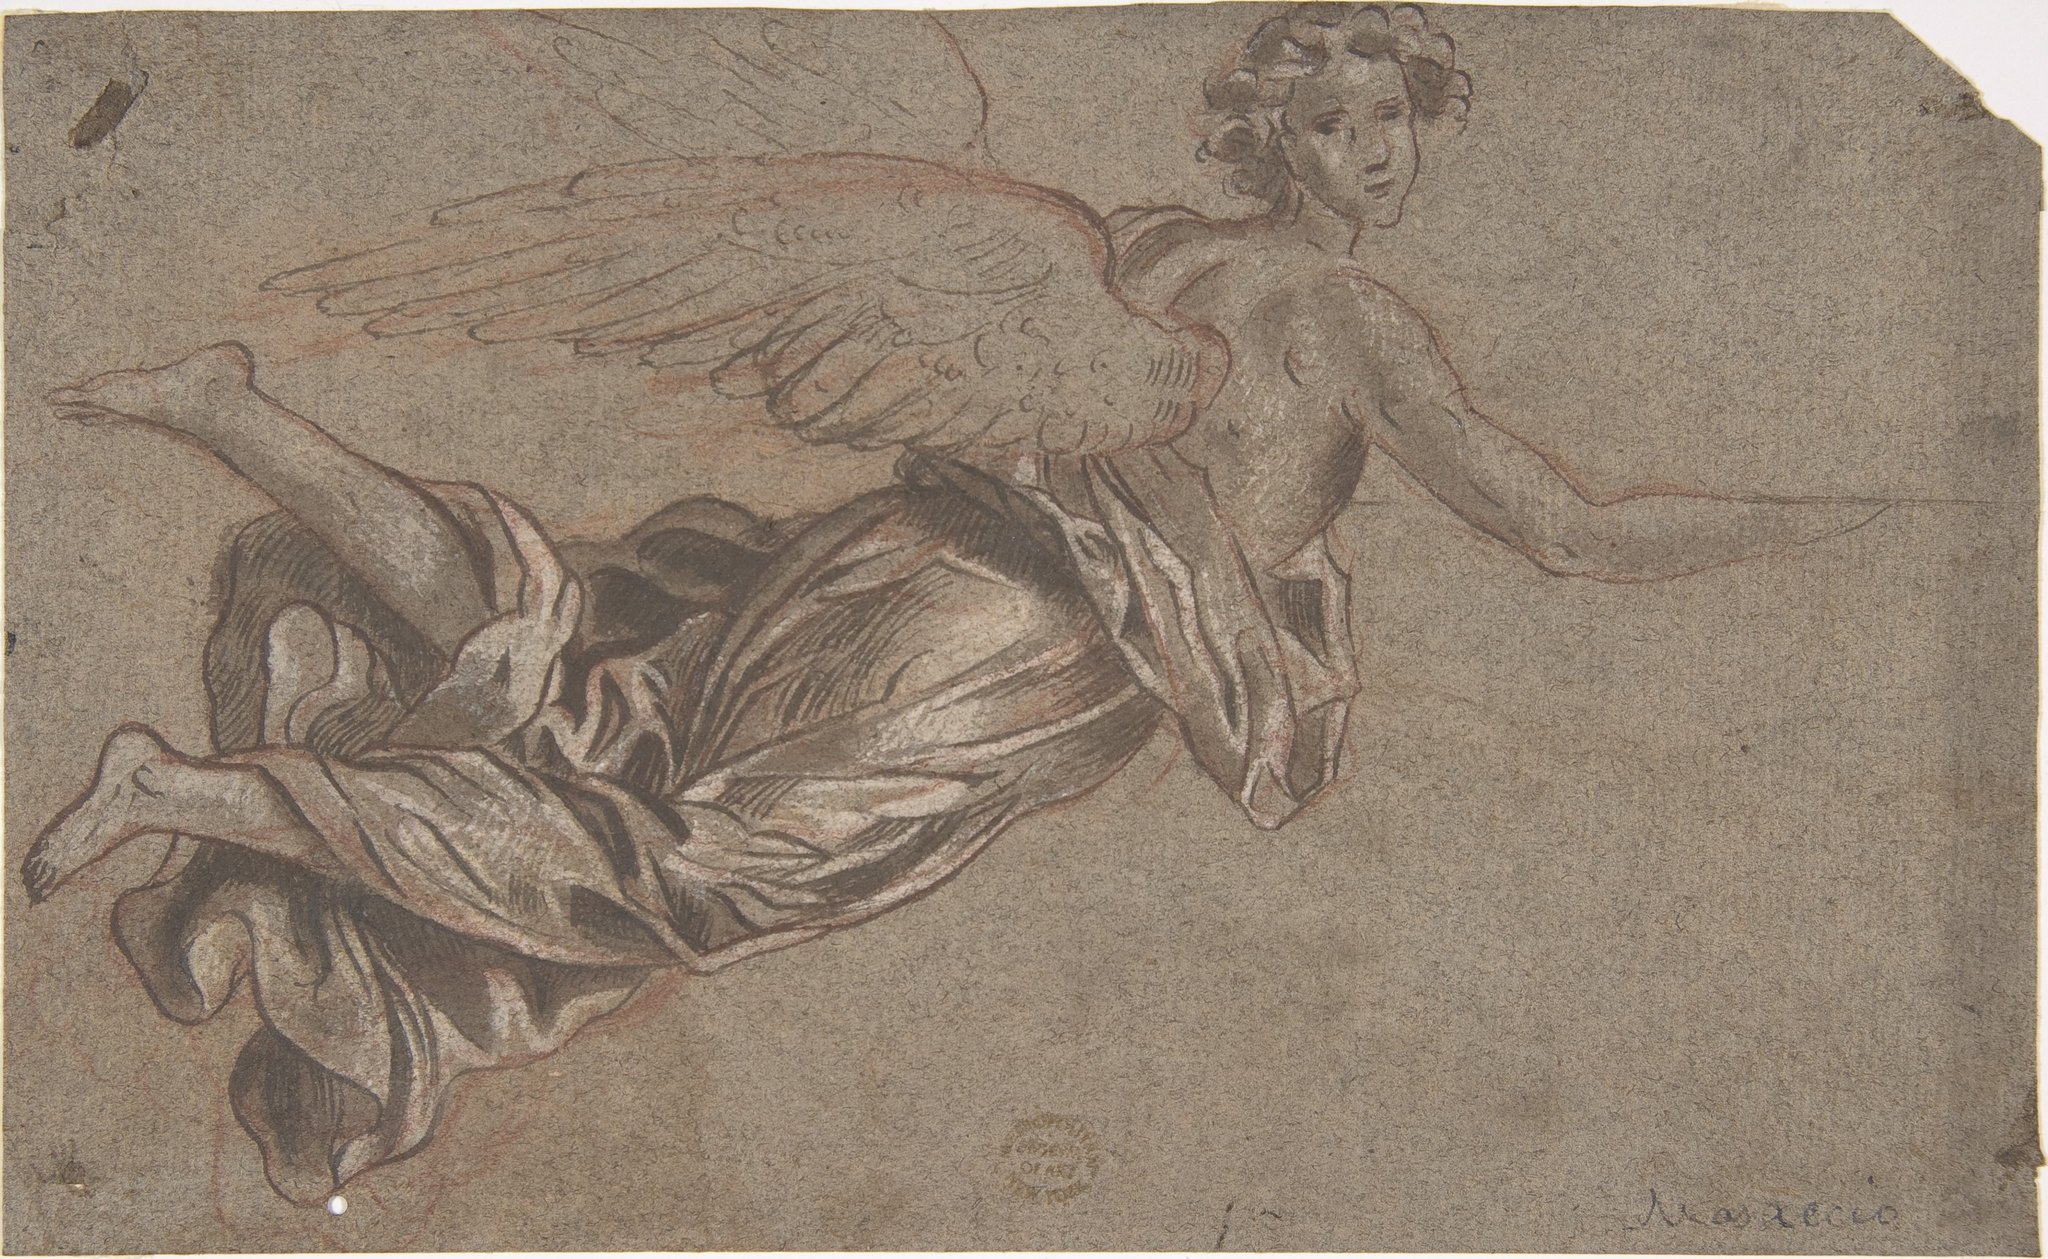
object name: drawing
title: Flying Angel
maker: anonymous, italian, 17th century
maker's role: artist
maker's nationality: italian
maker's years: 1600-1700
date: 1601-1700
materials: chalk, gouache, ink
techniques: brush, pen, wash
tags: angels